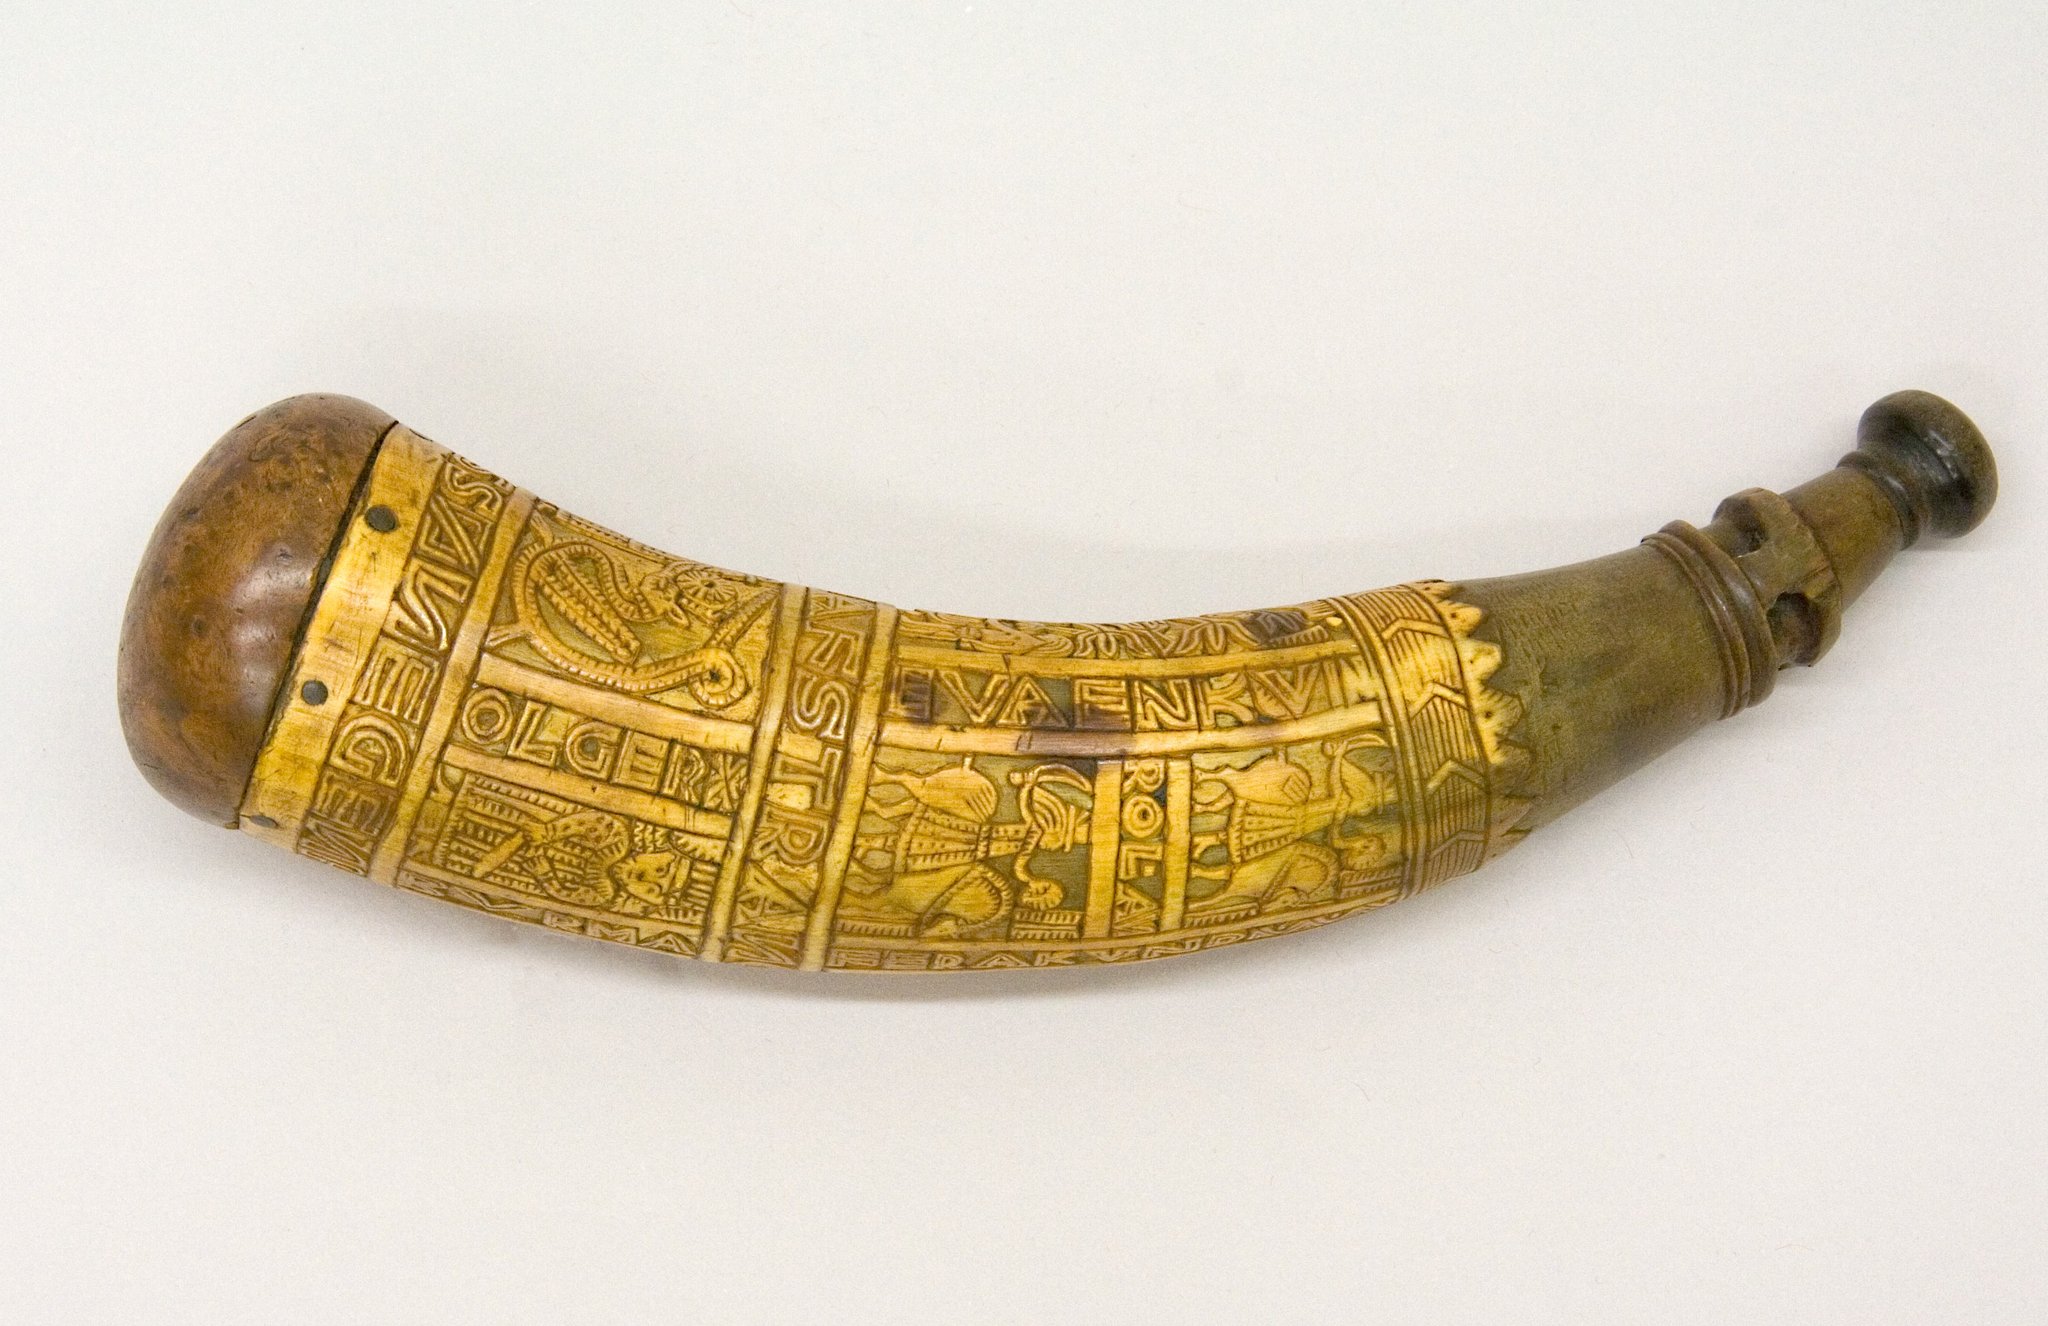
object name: powder flask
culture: norwegian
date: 1700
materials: horn, wood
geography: norway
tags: men,horses